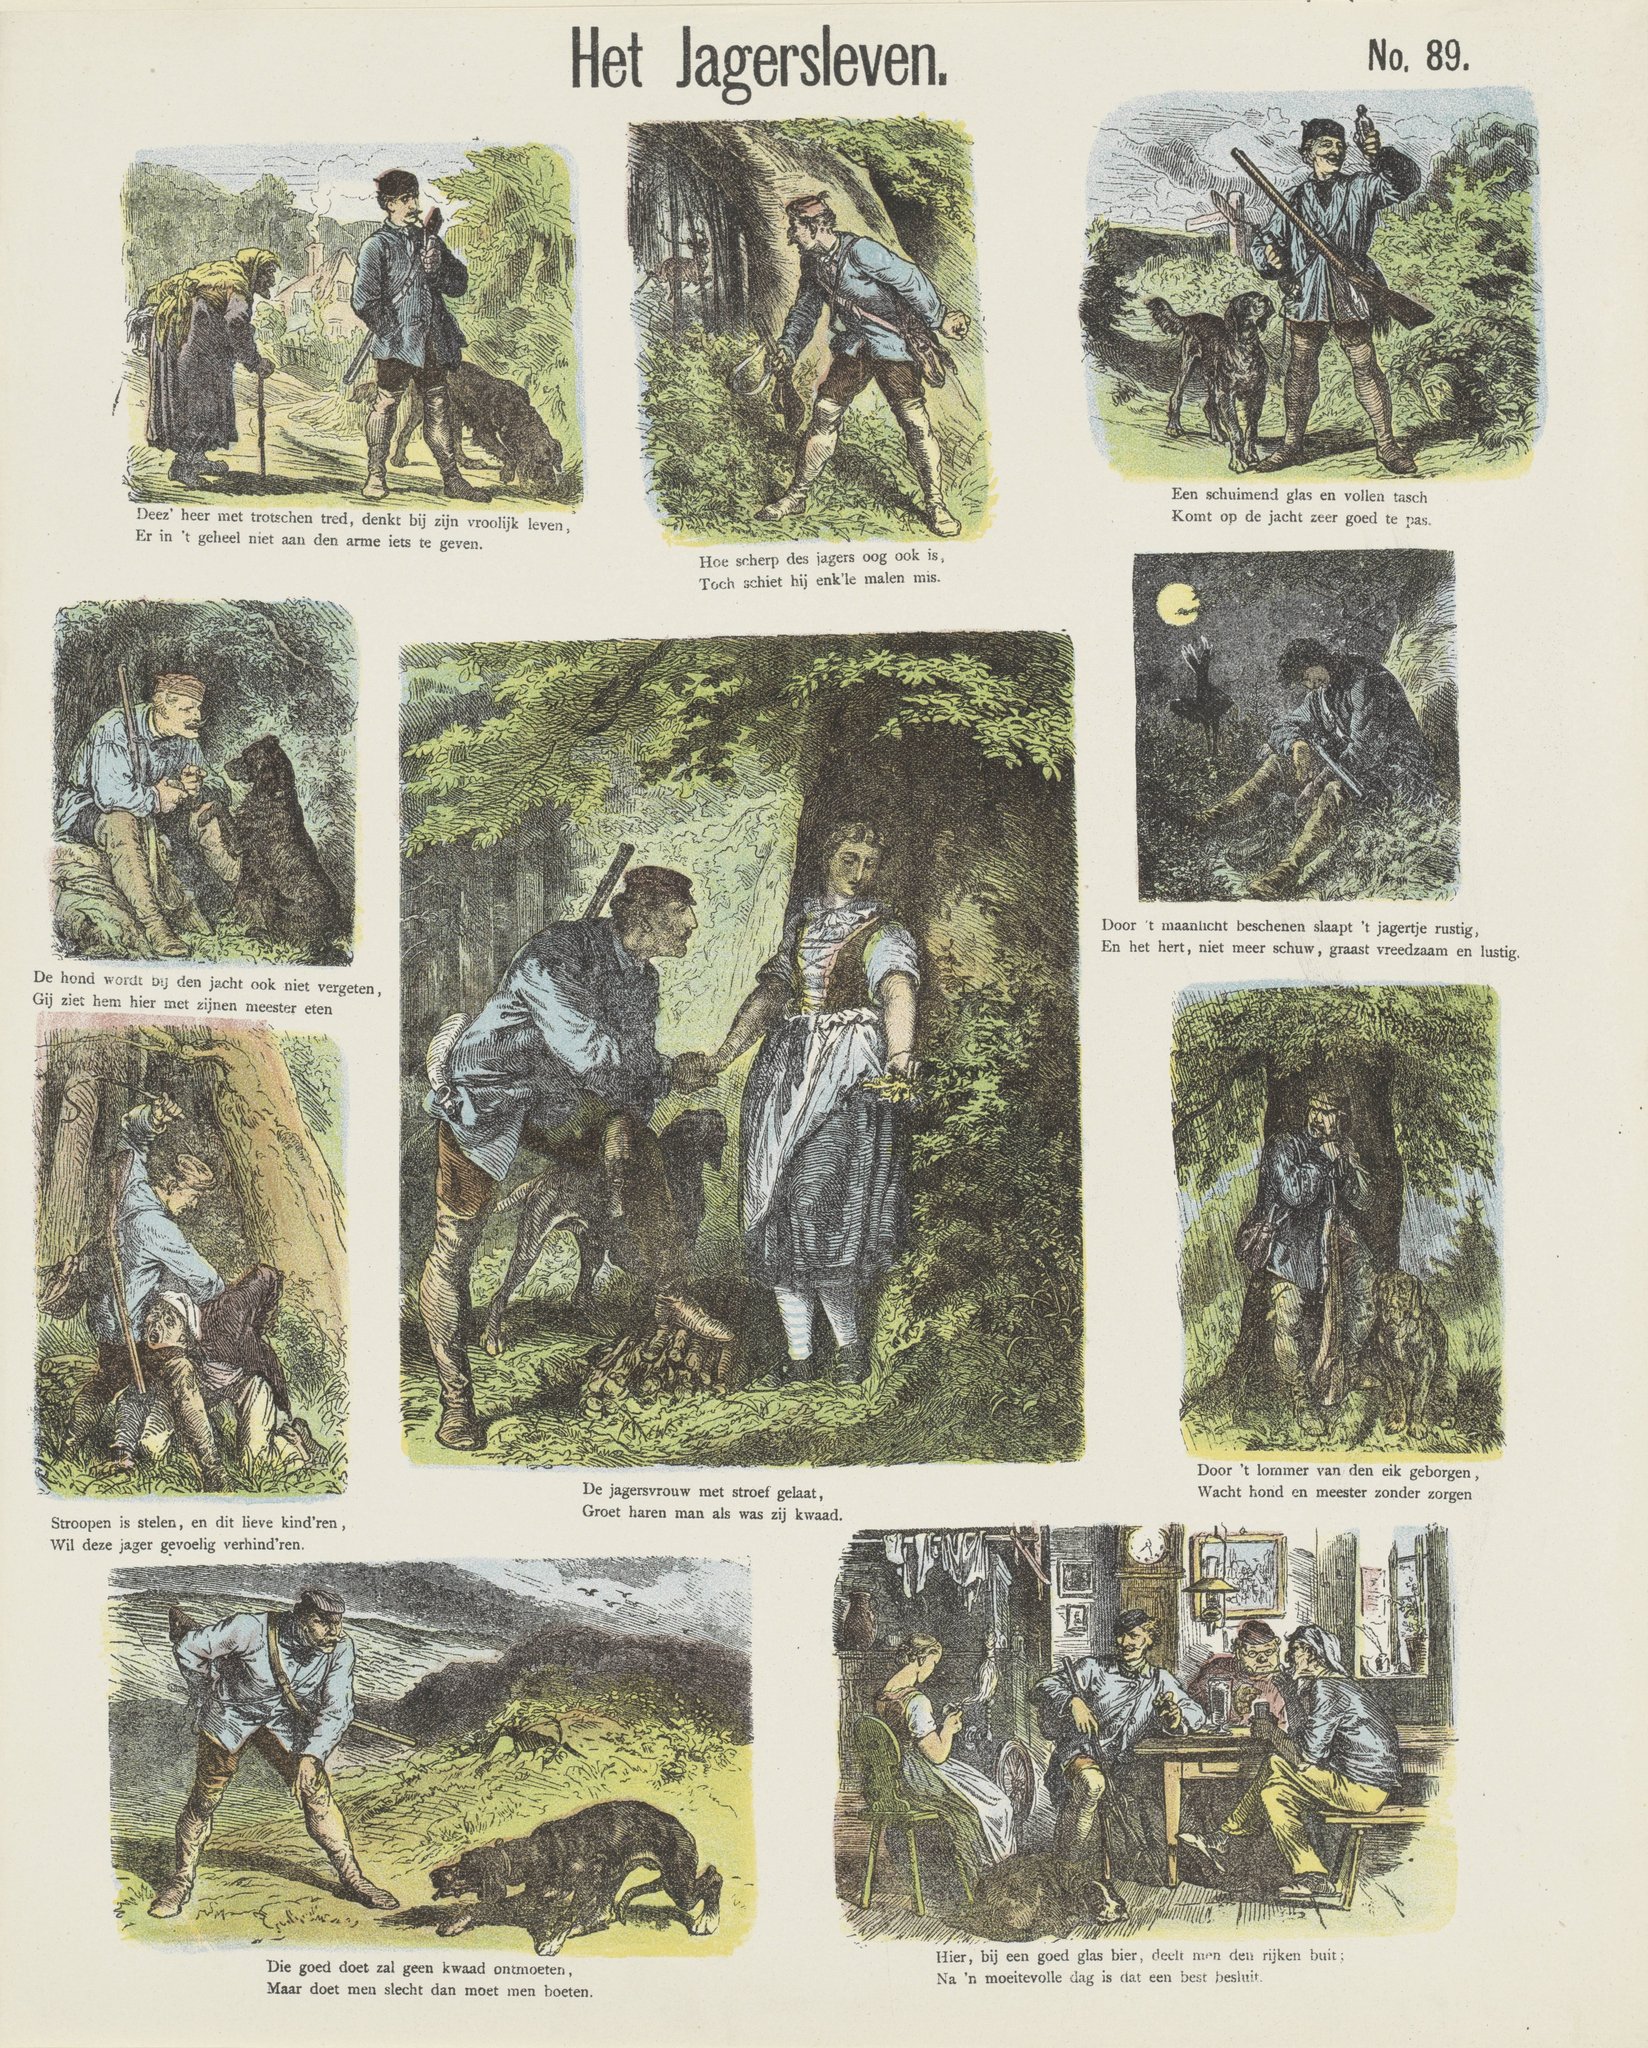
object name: popular print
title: Meijer's prenten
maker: Anonymous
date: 1881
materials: paper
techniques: lithograph, letterpress printing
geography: amsterdam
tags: hunting dogs, hunter, hunters resting during the hunt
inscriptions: collector's mark: Lugt 2760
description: Blad met 10 voorstellingen over het leven van een jager. Onder elke afbeelding een tweeregelig vers. Genummerd rechtsboven: No. 89.